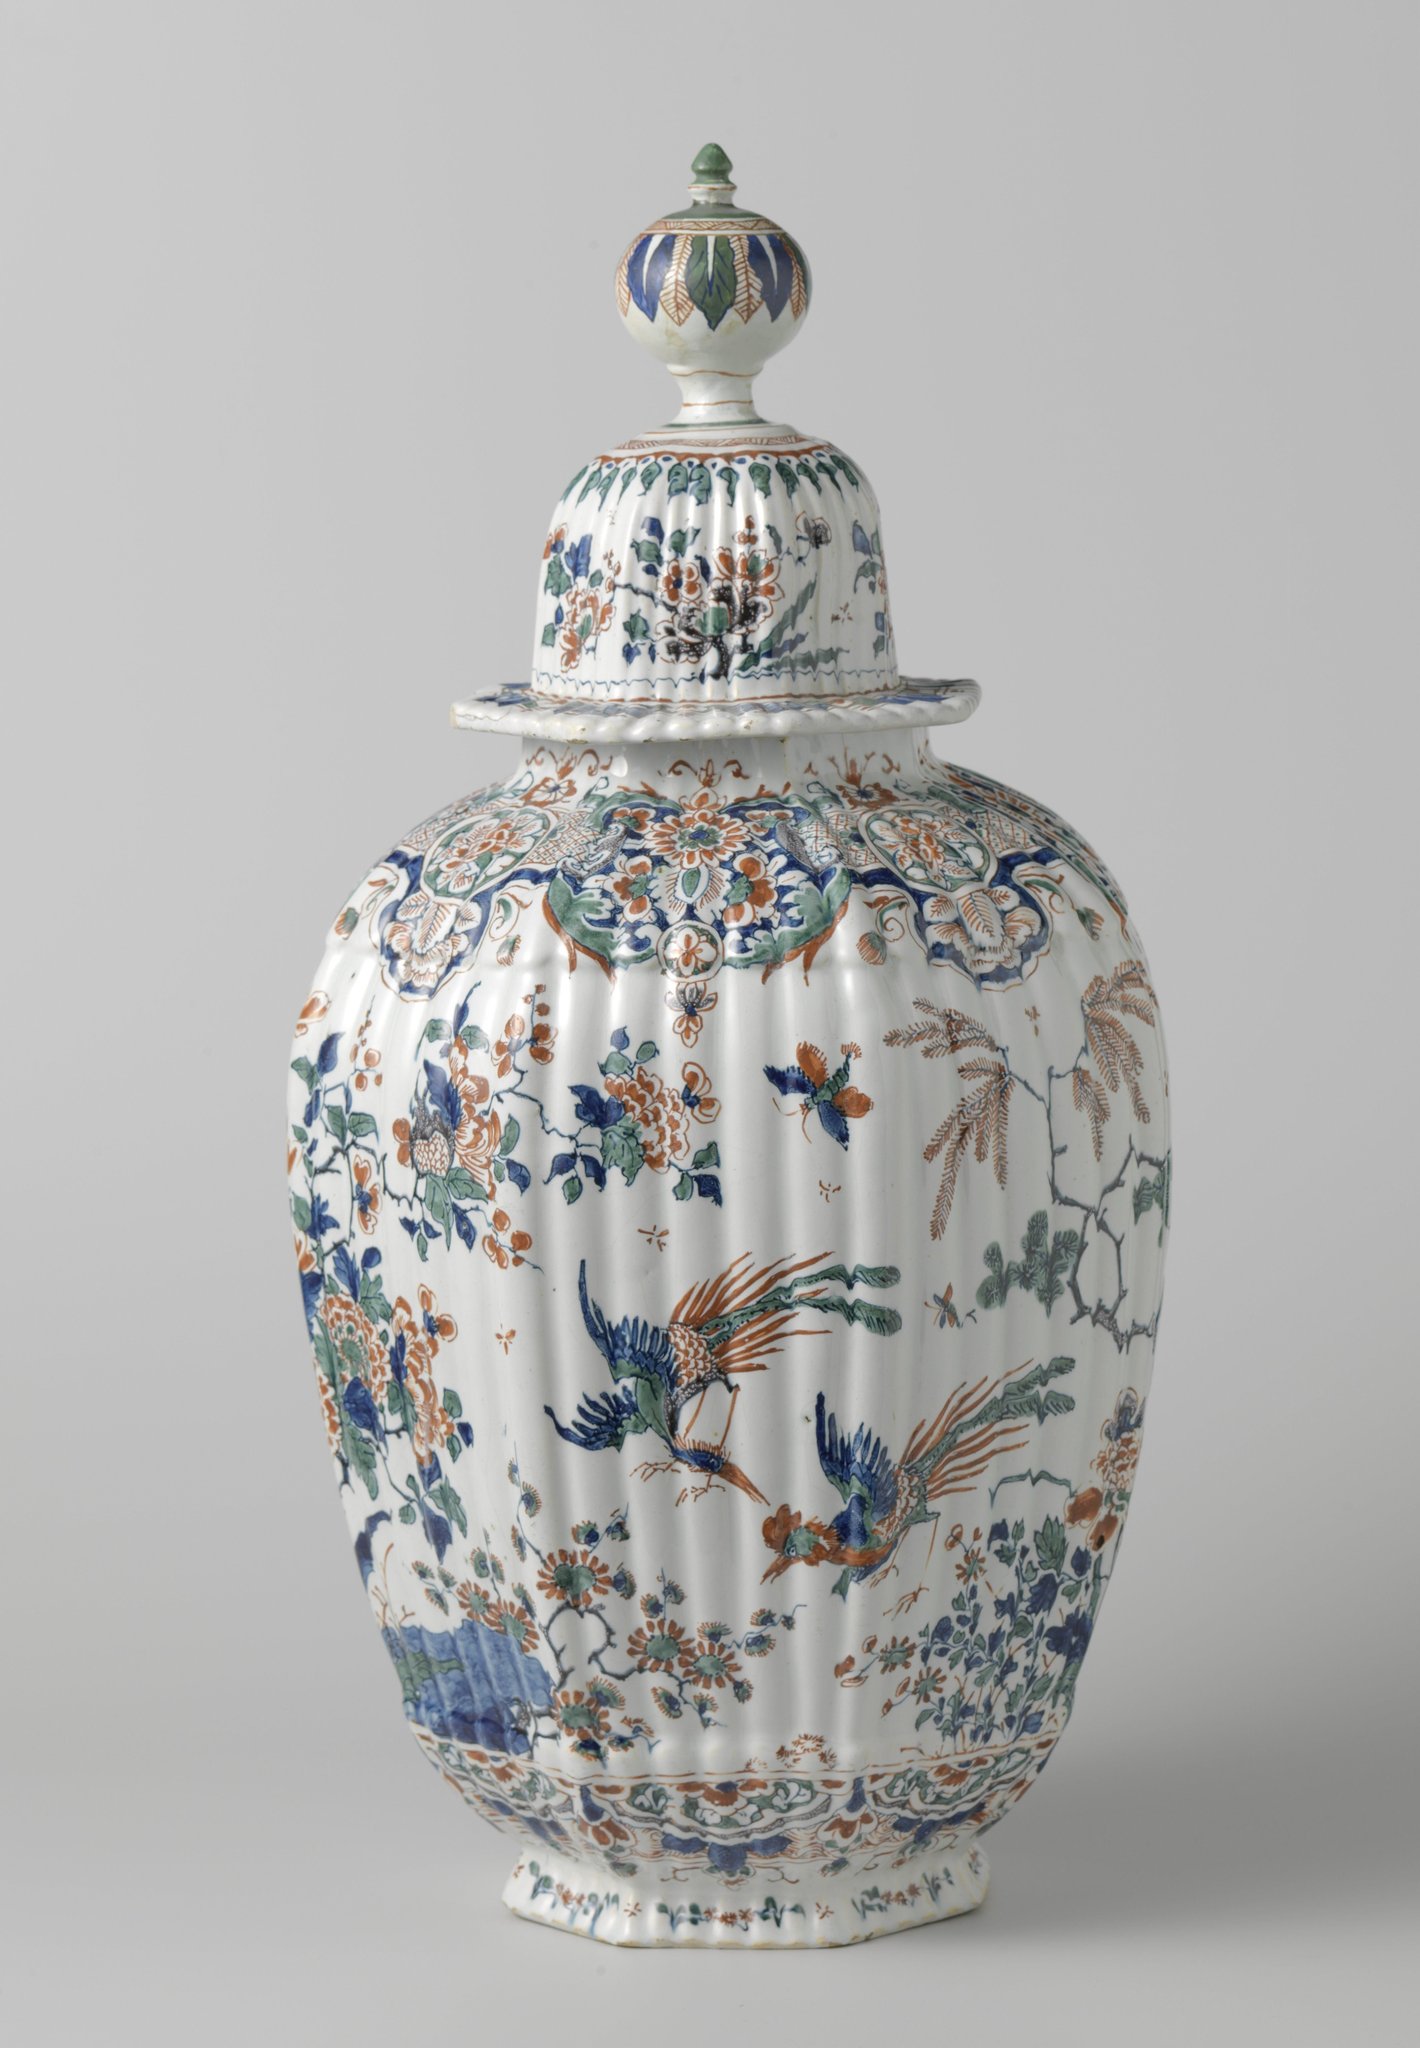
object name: vase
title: Achtkantige geribde vaas met deksel van veelkleurig beschilderde faïence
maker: lambertus van eenhoorn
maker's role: plateelbakker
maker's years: 1651-1721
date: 1695-1725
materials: earthenware, glaze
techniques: painted, polychromy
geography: delft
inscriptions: mark: ‘LVE (ineen)/ IVK/ 3/ c’, collector's mark: ‘collection J.F. Loudon’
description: Achtkantige, geribde vaas van veelkleurig beschilderde faïence. De vaas is beschilderd met bloemen, rotsen, vogels en een vogel in een boom. De vaas is onderdeel van een stel, de andere delen zijn: drie identieke potten en een identieke vaas. De delen zijn gemerkt.